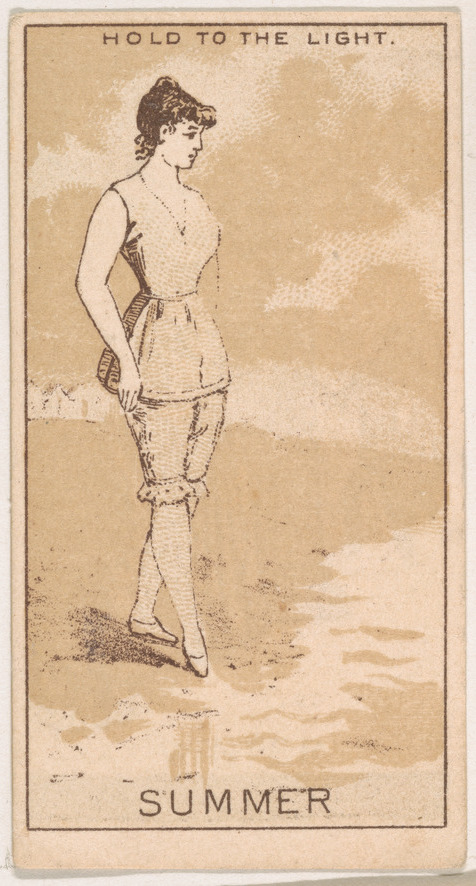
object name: print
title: Summer, from the Magic Changing Cards series (N223) issued by Kinney Tobacco Company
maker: kinney brothers tobacco company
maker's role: publisher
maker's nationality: american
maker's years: 1869-2011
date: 1889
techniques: color lithograph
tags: profiles,women